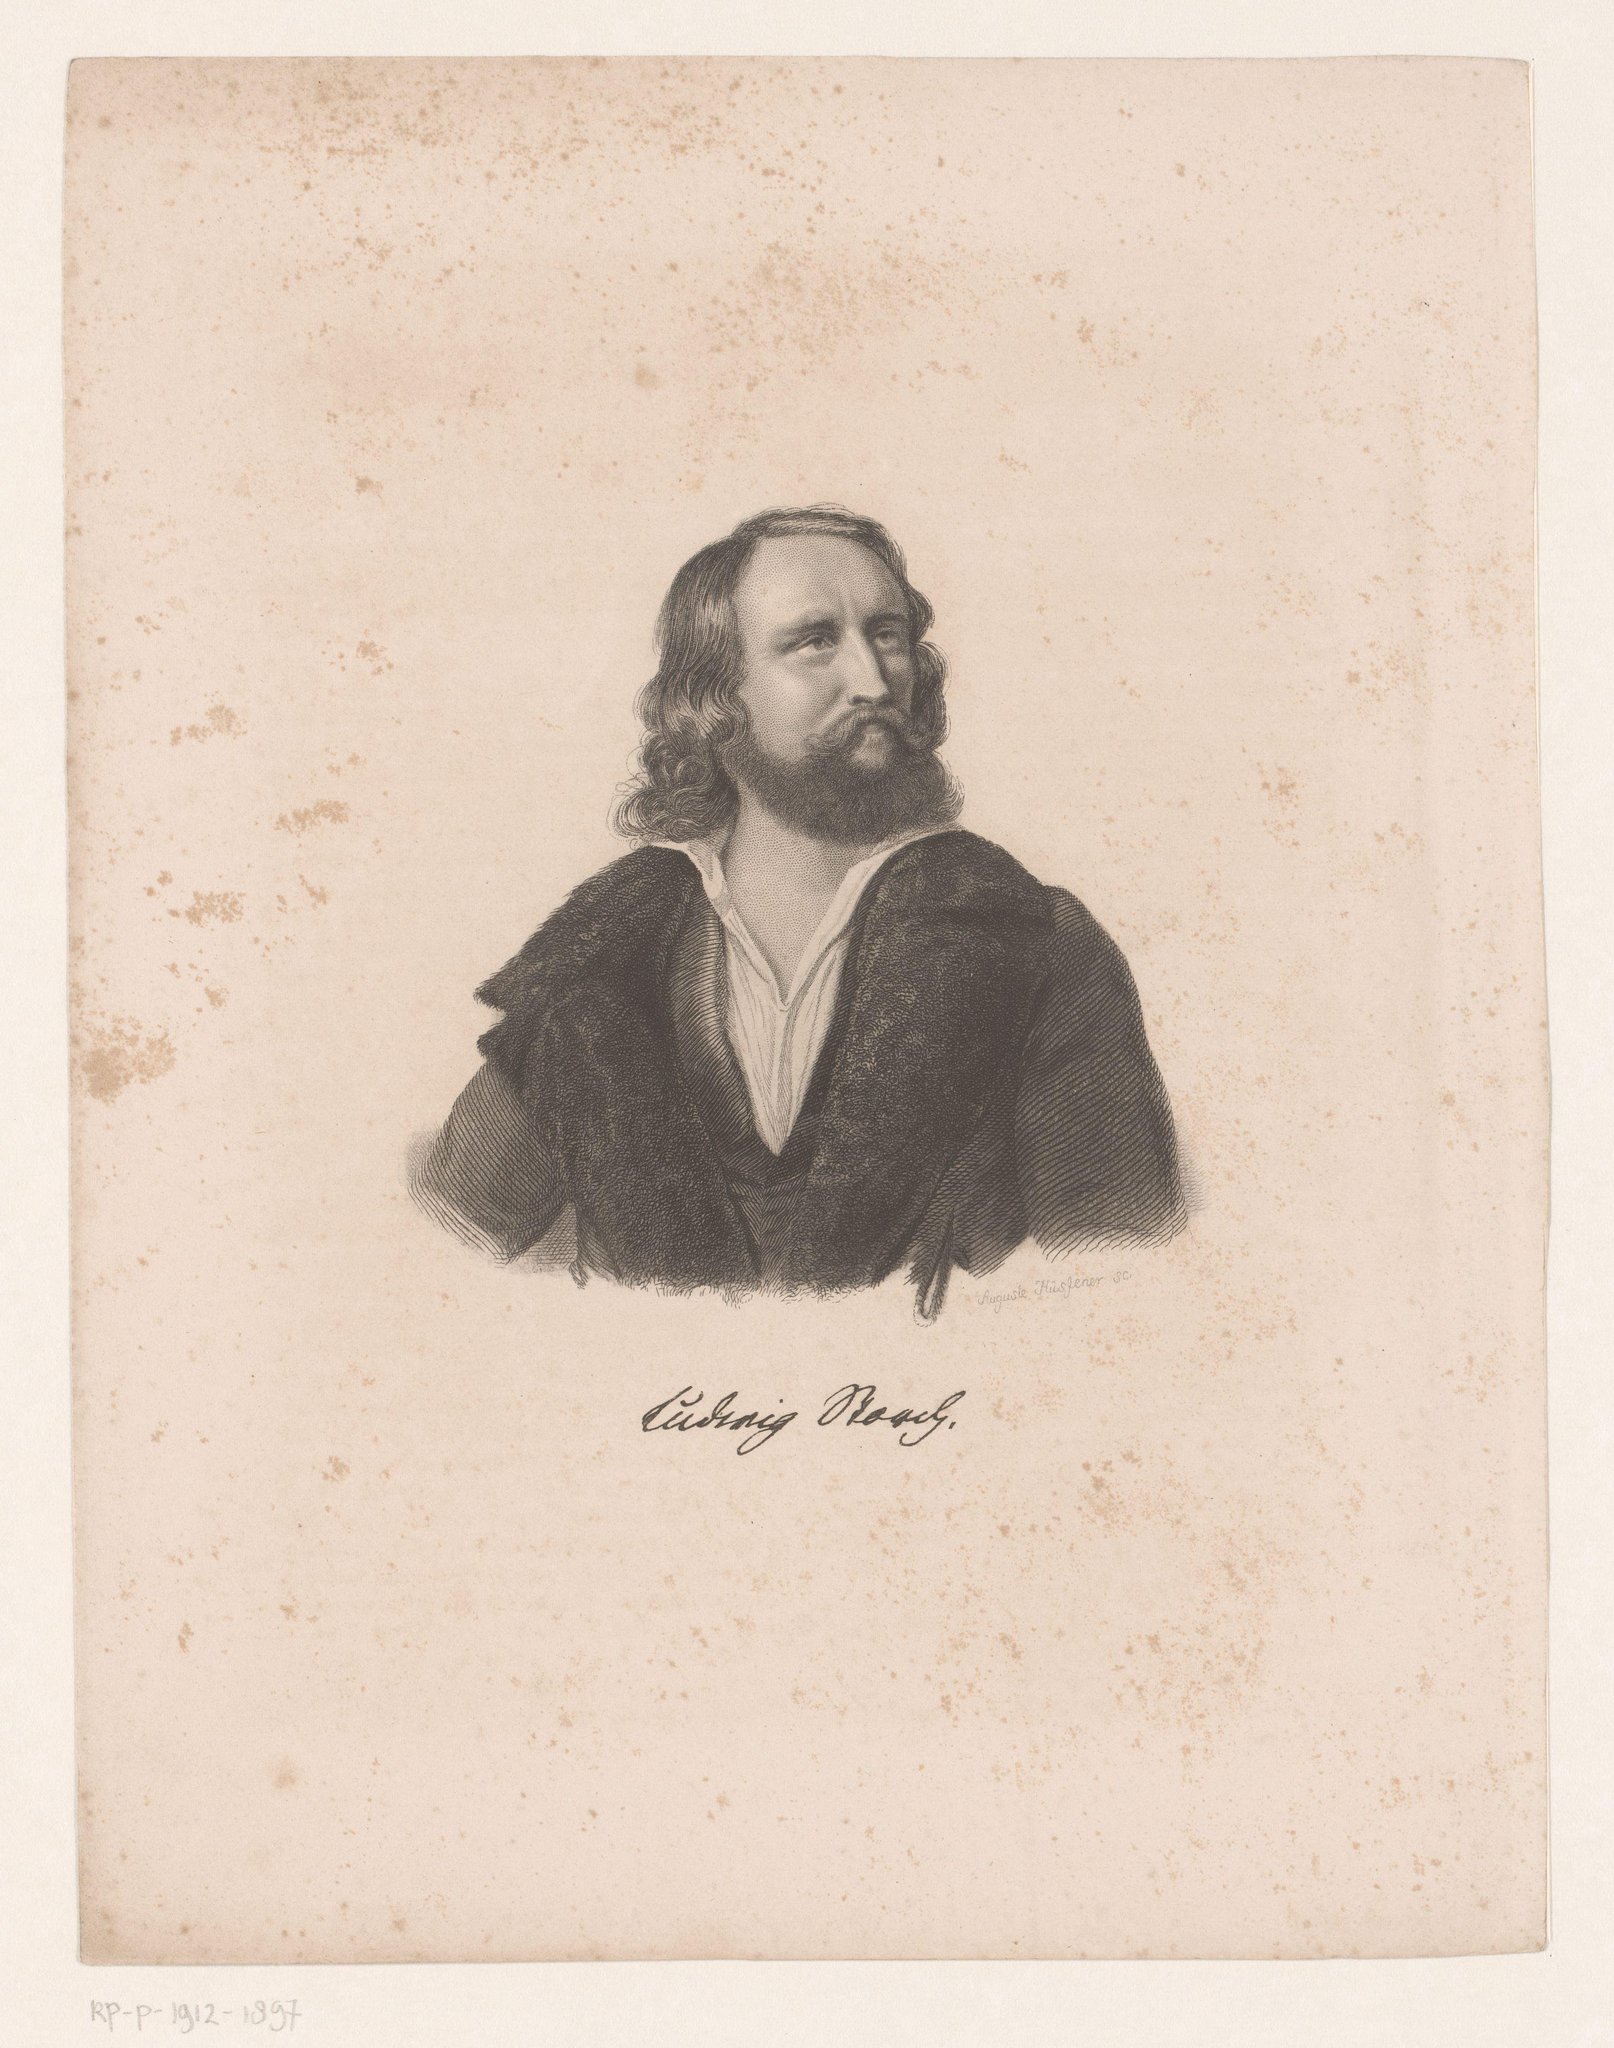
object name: print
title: Portret van Ludwig Storck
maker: auguste hüssener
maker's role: print maker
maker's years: 1789-1877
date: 1799-1877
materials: paper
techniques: etching, intaglio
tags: mayor, mayor, burgomaster, historical persons, merchant, salesman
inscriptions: collector's mark: Lugt 2228